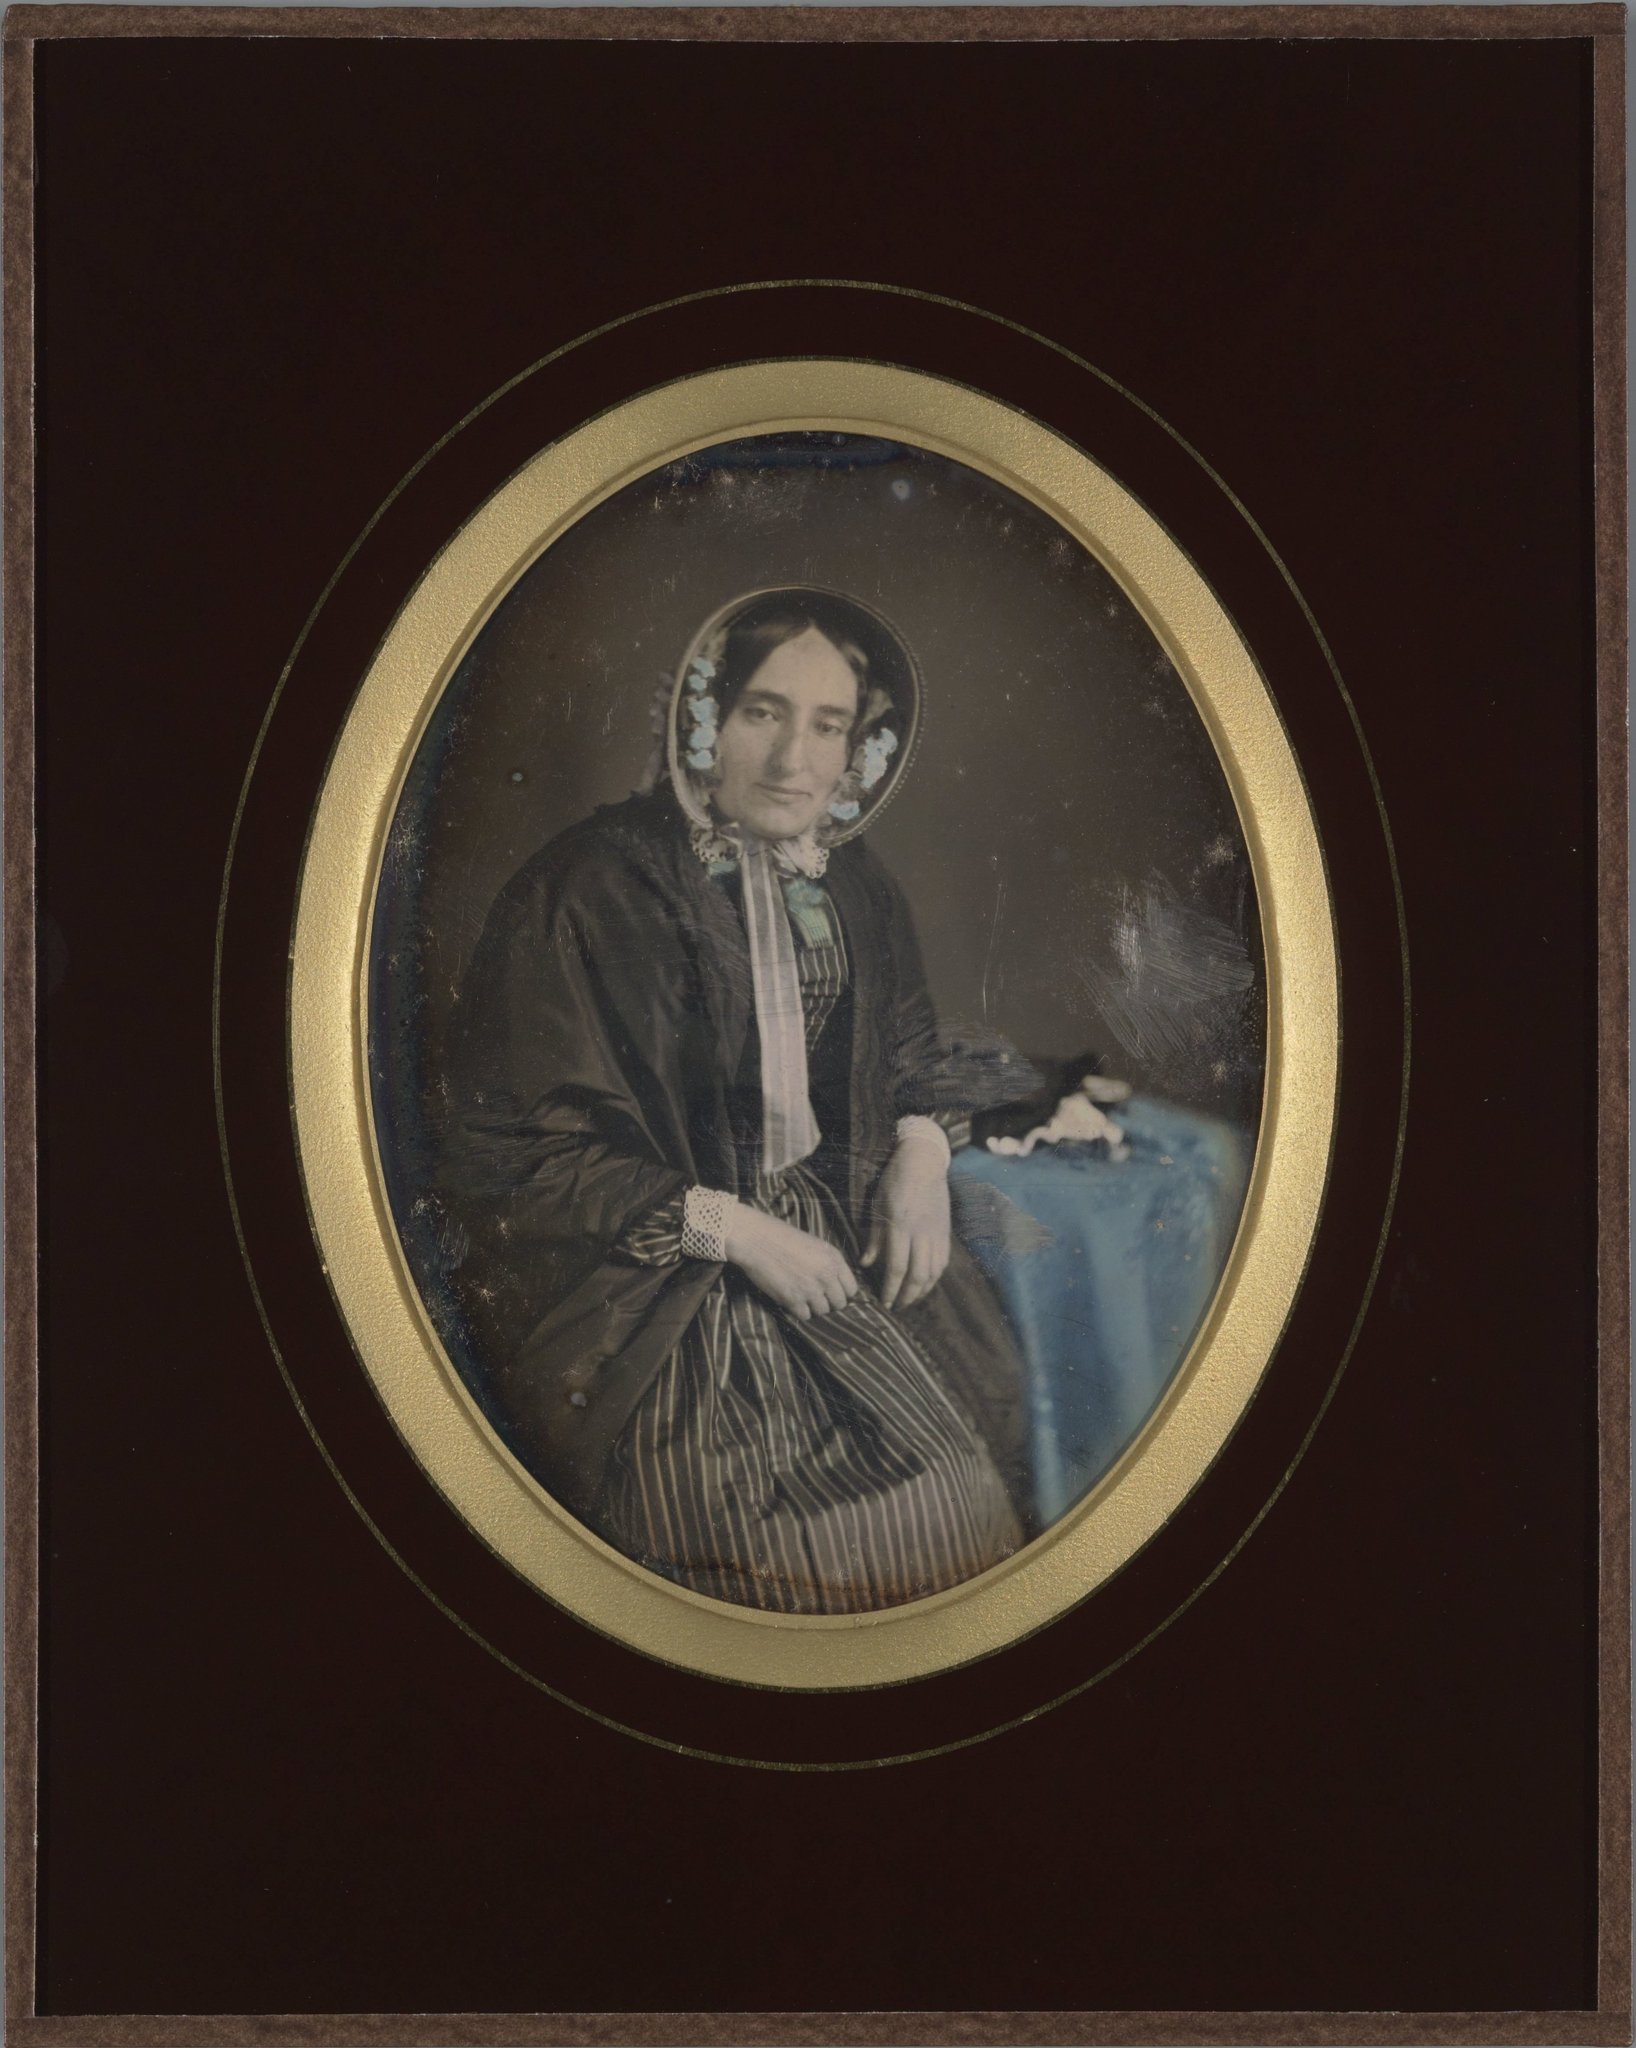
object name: photograph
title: Portret van een onbekende vrouw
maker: Anonymous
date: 1840-1860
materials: copper, glass, paper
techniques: daguerreotype, hand coloring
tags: adult woman, historical persons